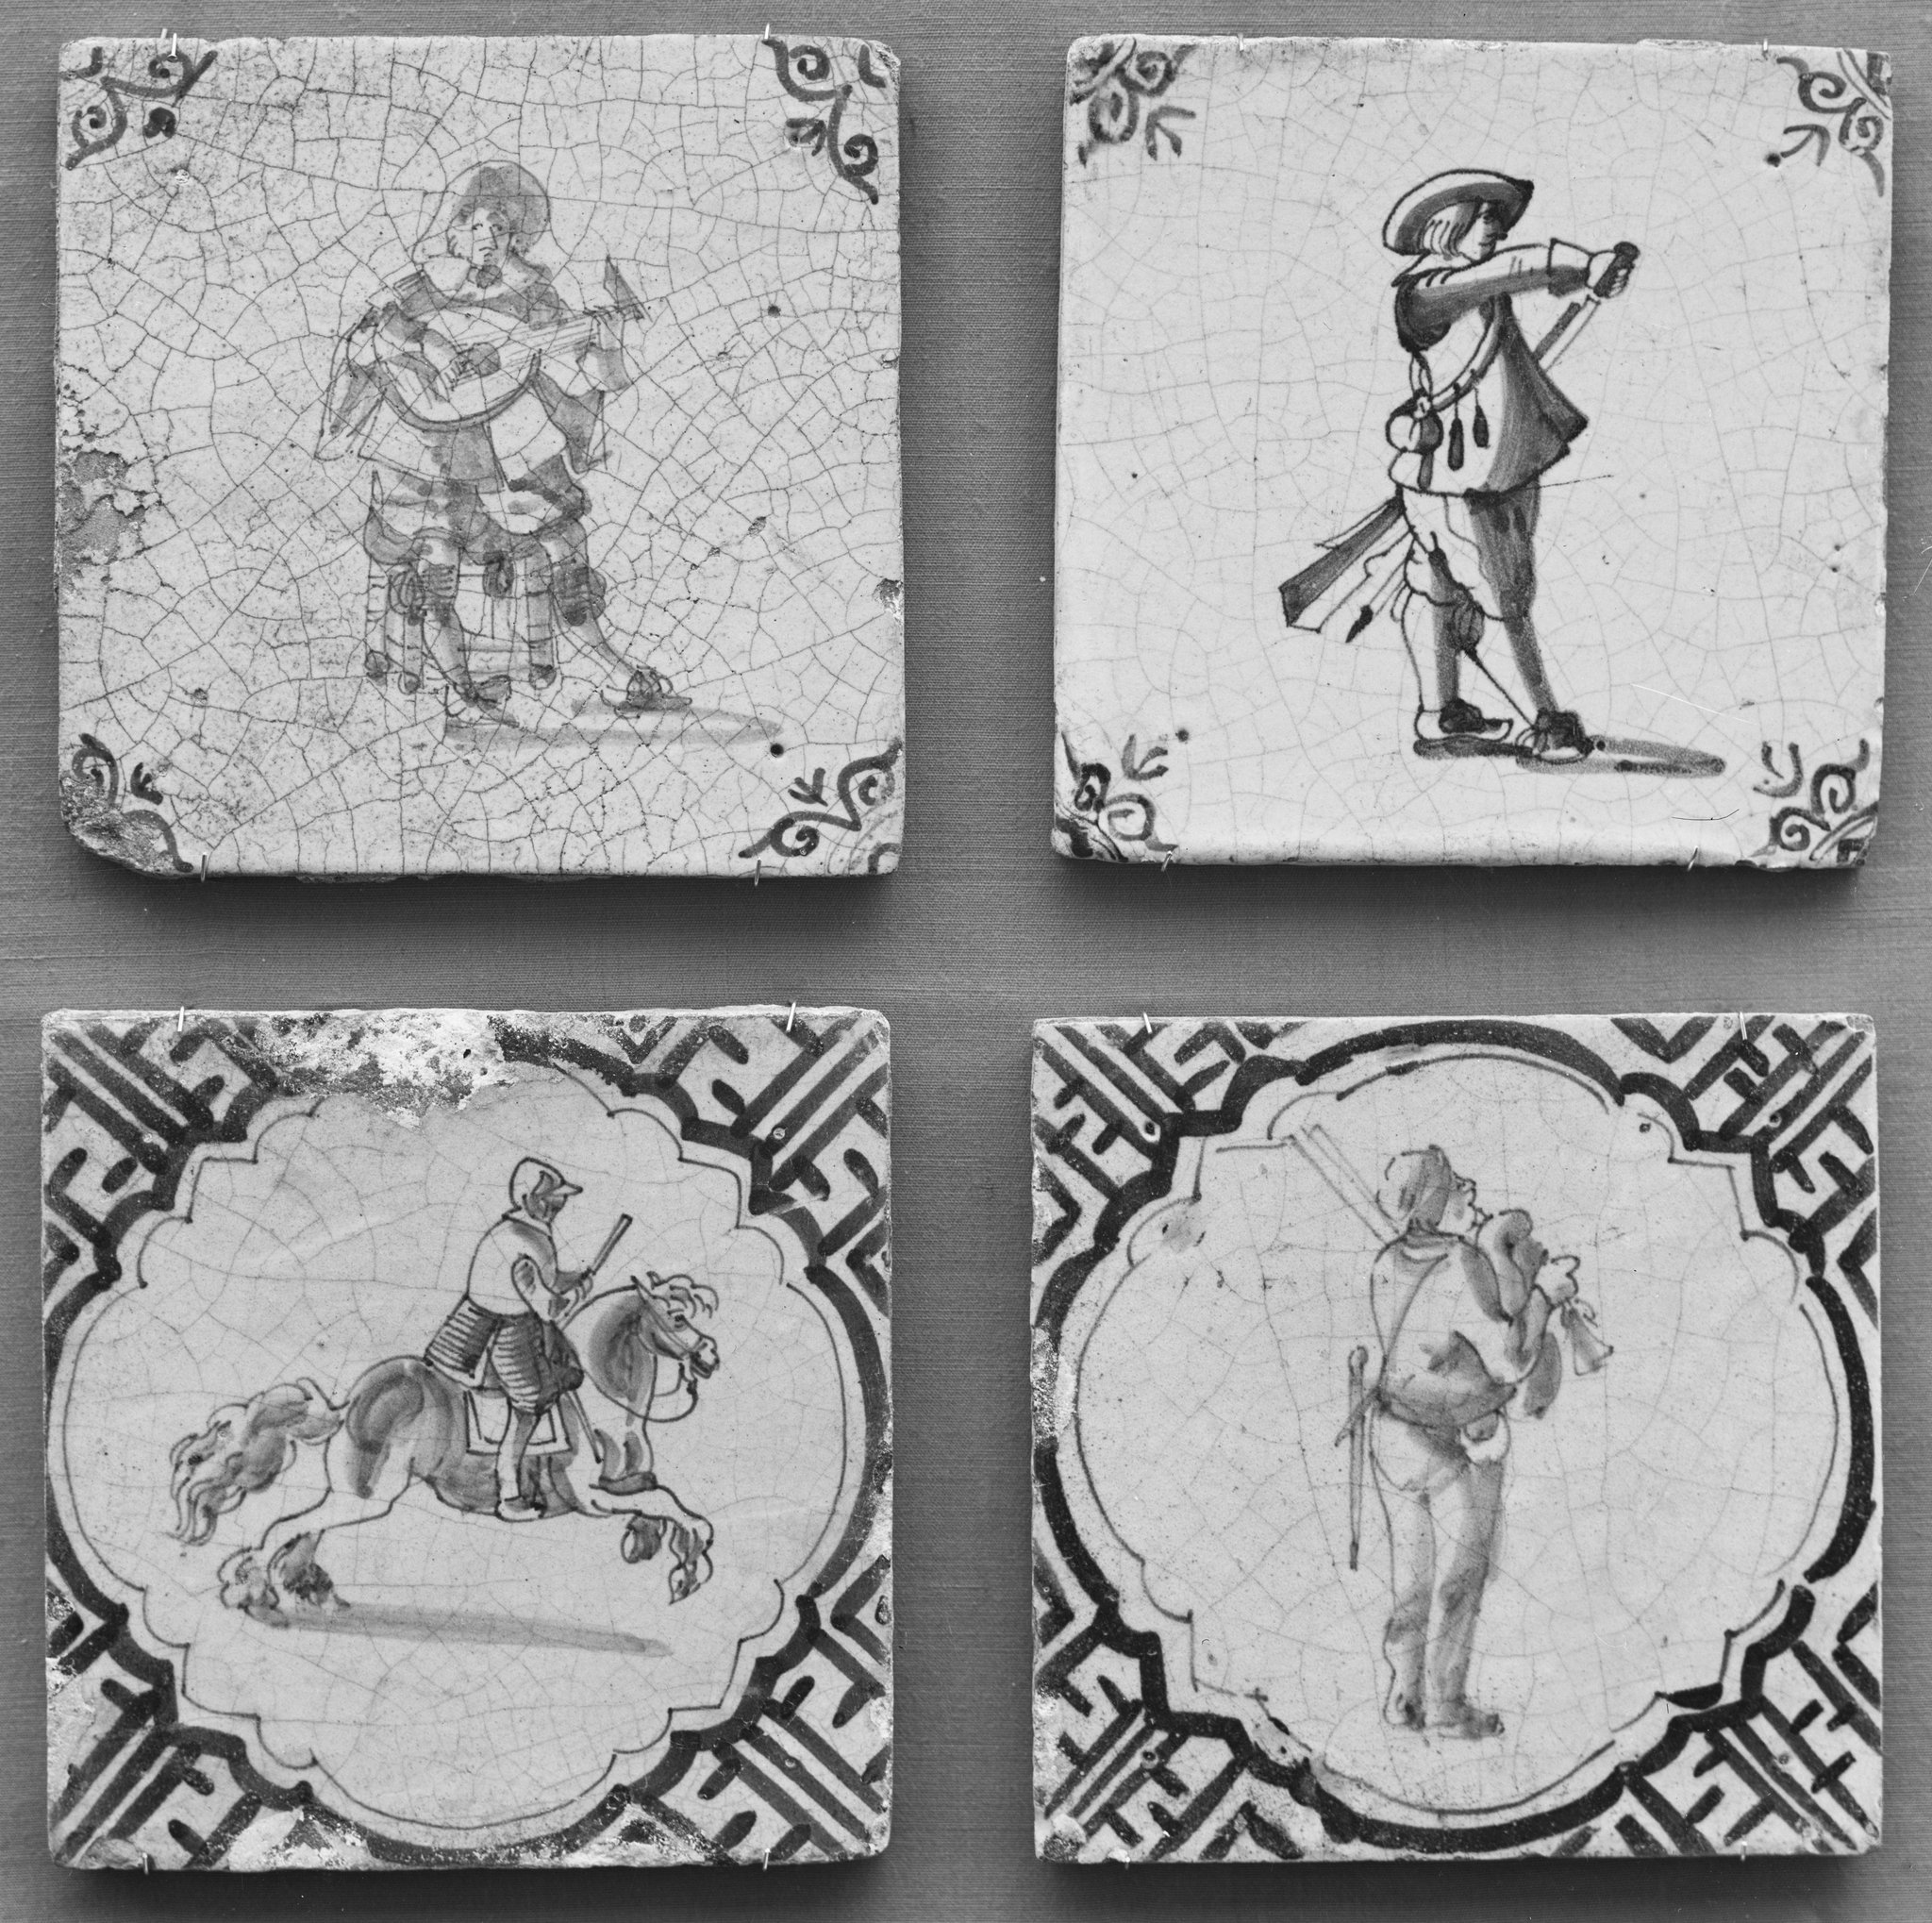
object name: tile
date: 1620-1640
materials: earthenware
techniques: glazing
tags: musical instruments,men,horses